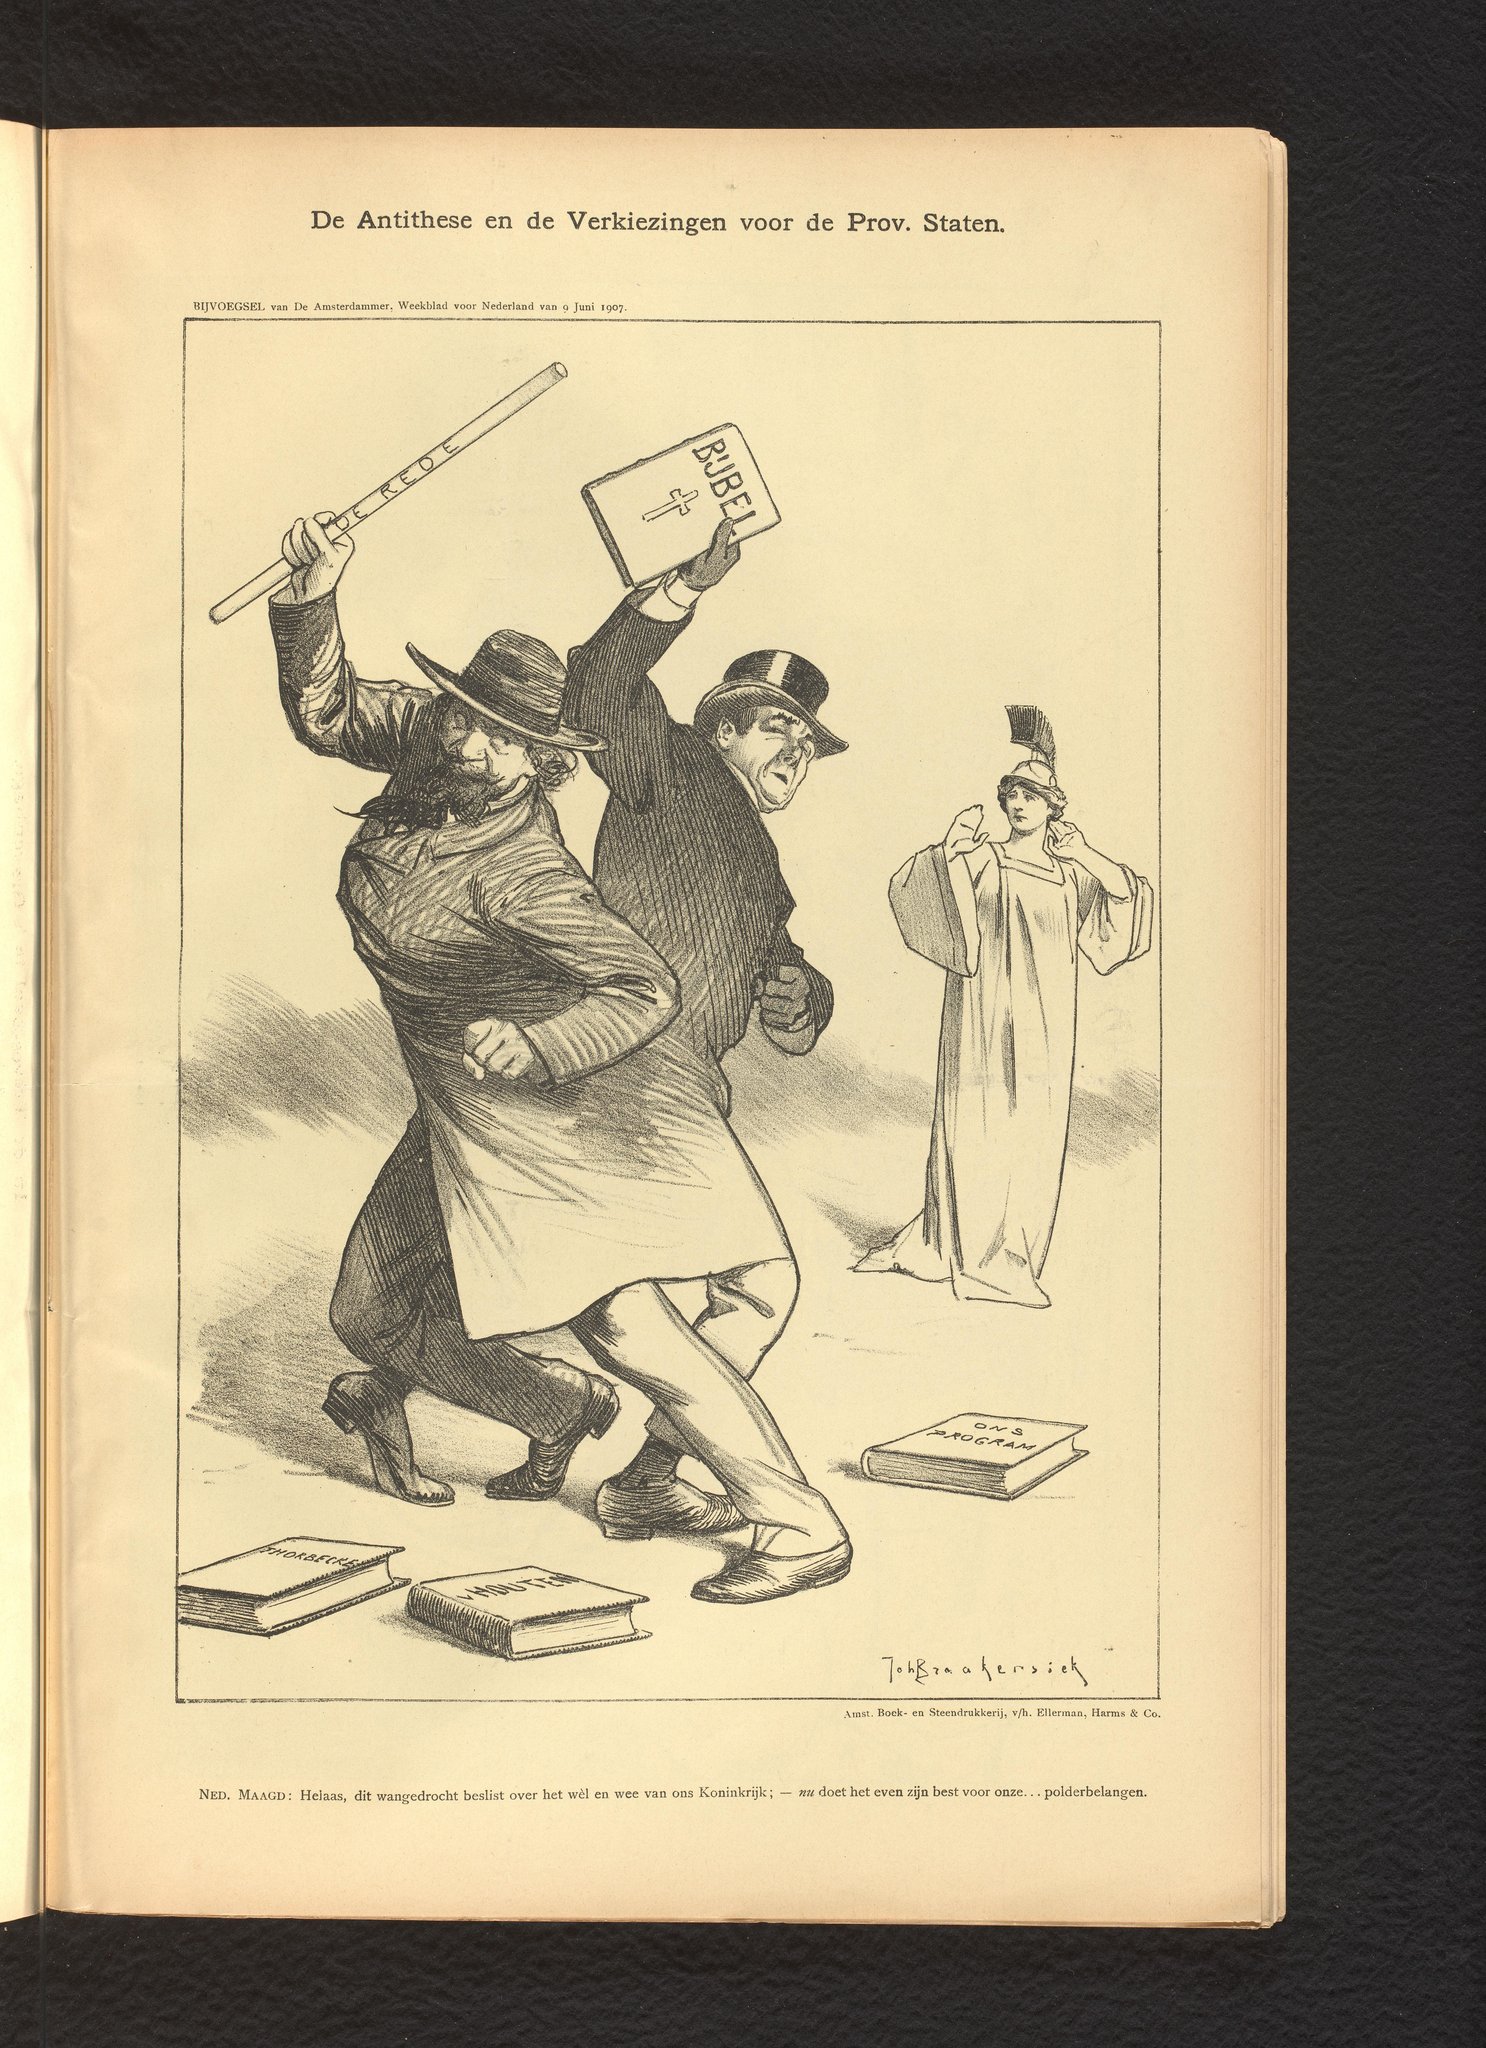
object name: cartoon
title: De Antithese en de Verkiezingen voor de Prov. Staten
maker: johan braakensiek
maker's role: draughtsman, print maker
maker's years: 1858-1940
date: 1907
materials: paper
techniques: lithograph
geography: amsterdam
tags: voting, election, personifications of countries, nations, states, districts, etc., political caricatures and satires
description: Twee mannen 'Rede' en 'Bijbel' samen in één jas worstelen met elkaar. De Nederlandse Maagd ziet bezorgd toe. Naar aanleiding van de verkiezingen voor de Provinciale Staten.